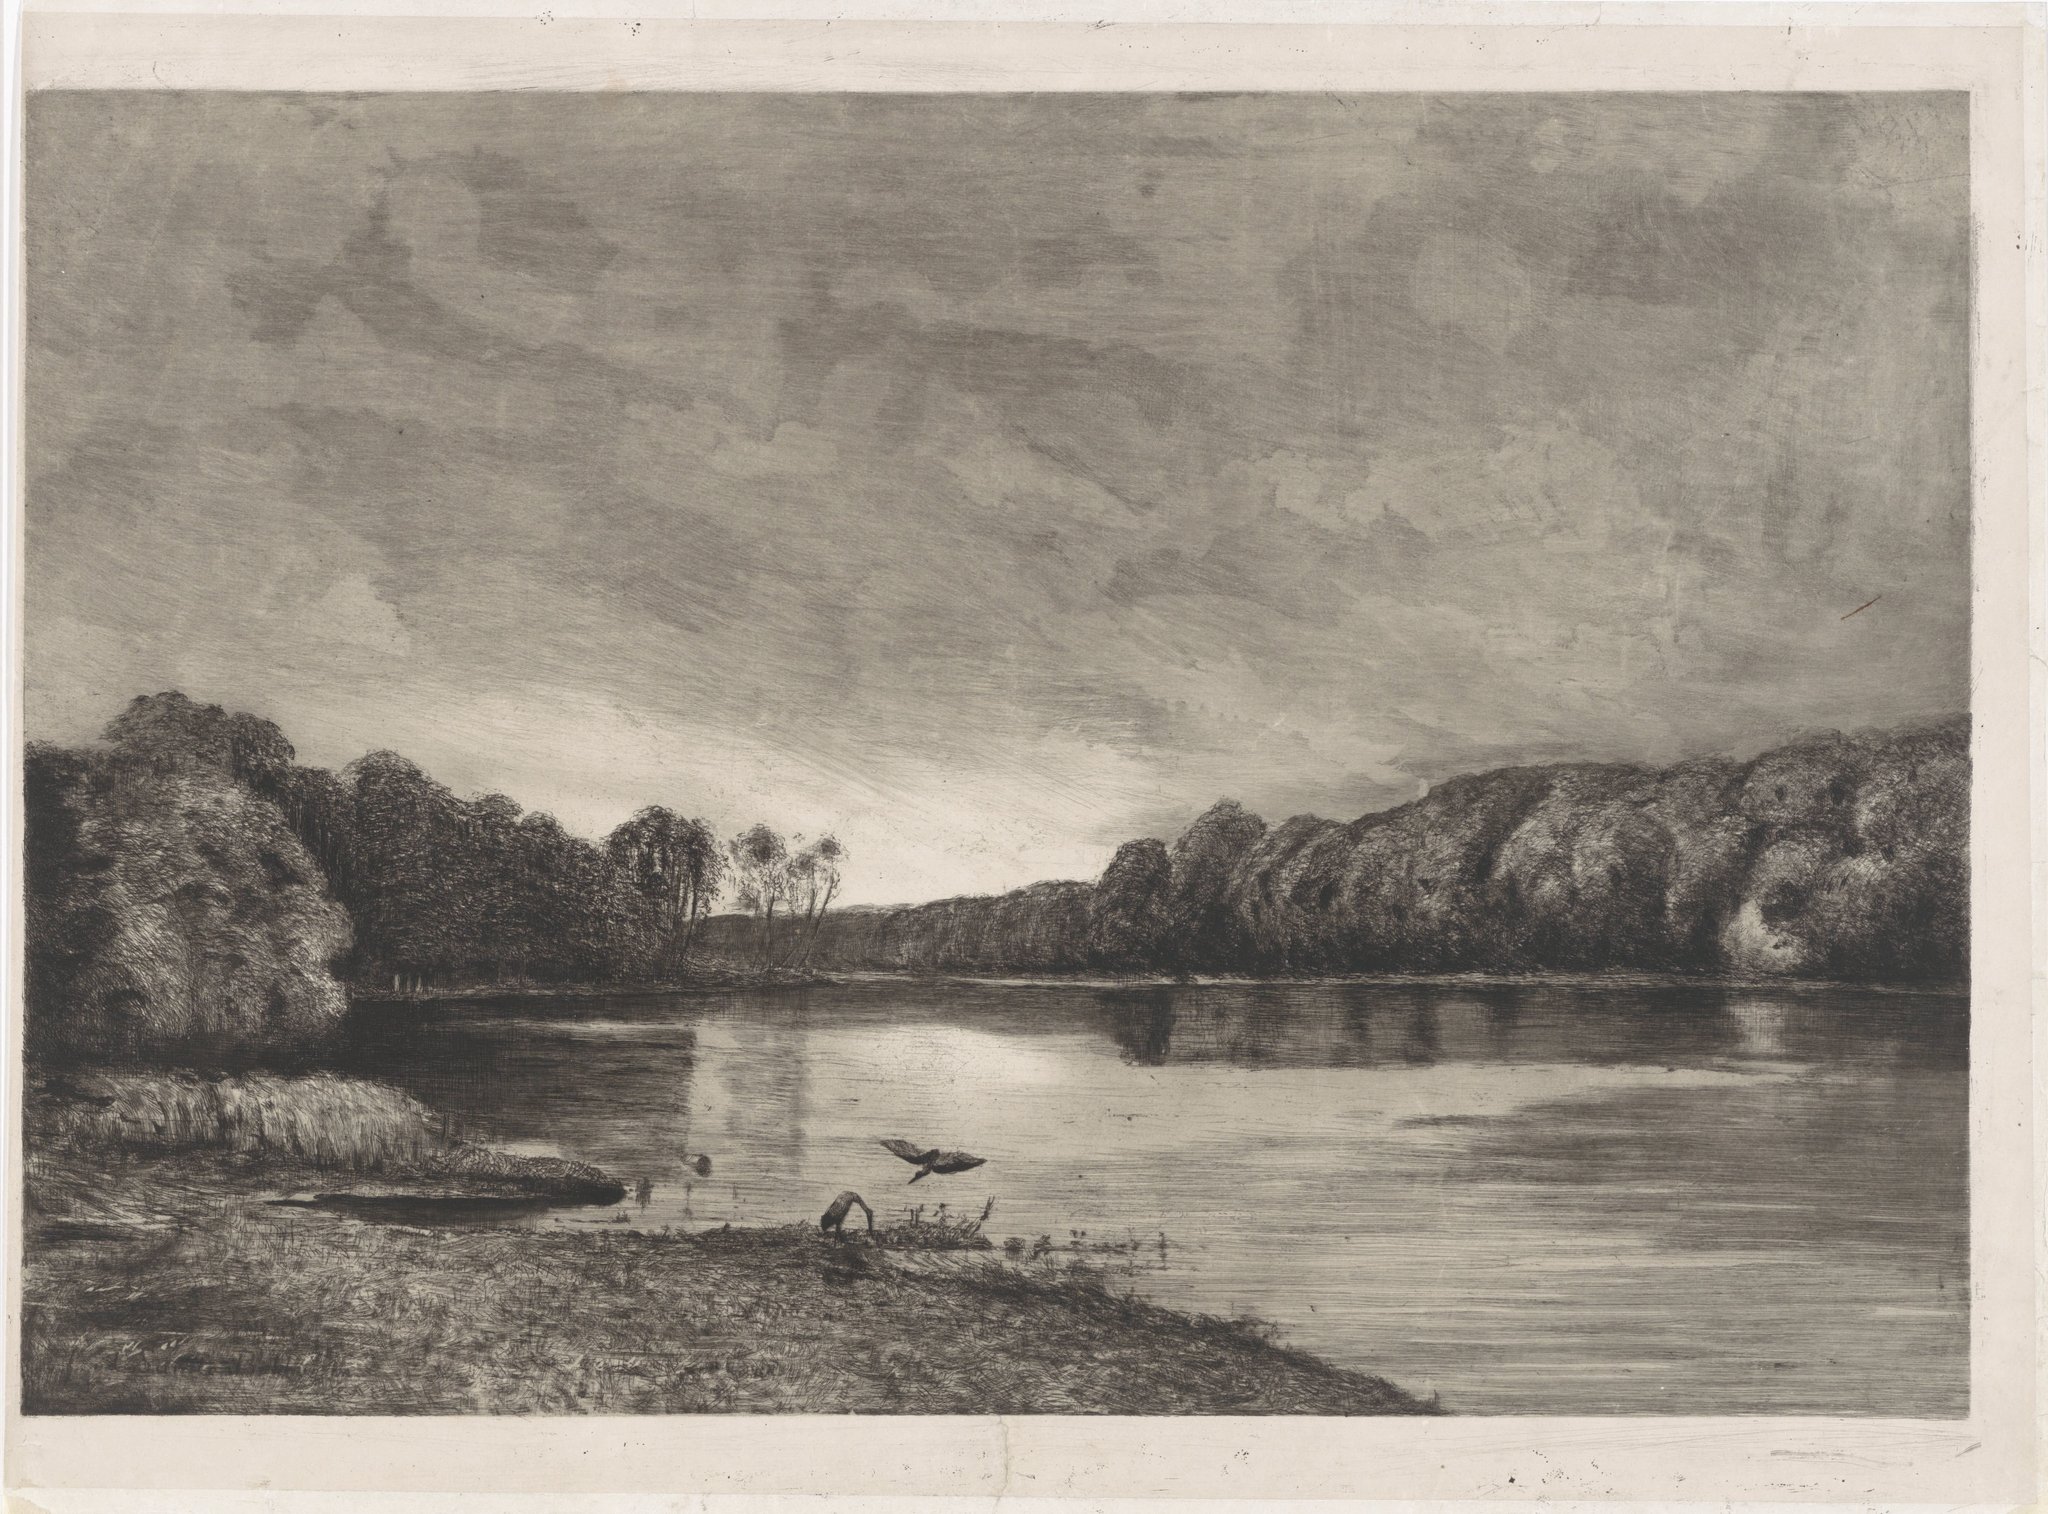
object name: print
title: Vijver met twee reigers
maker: Anonymous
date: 1850-1905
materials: paper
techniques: drypoint, etching, intaglio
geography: the hague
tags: shore-birds and wading-birds: heron, pond, pool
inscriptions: collector's mark: Lugt 2228